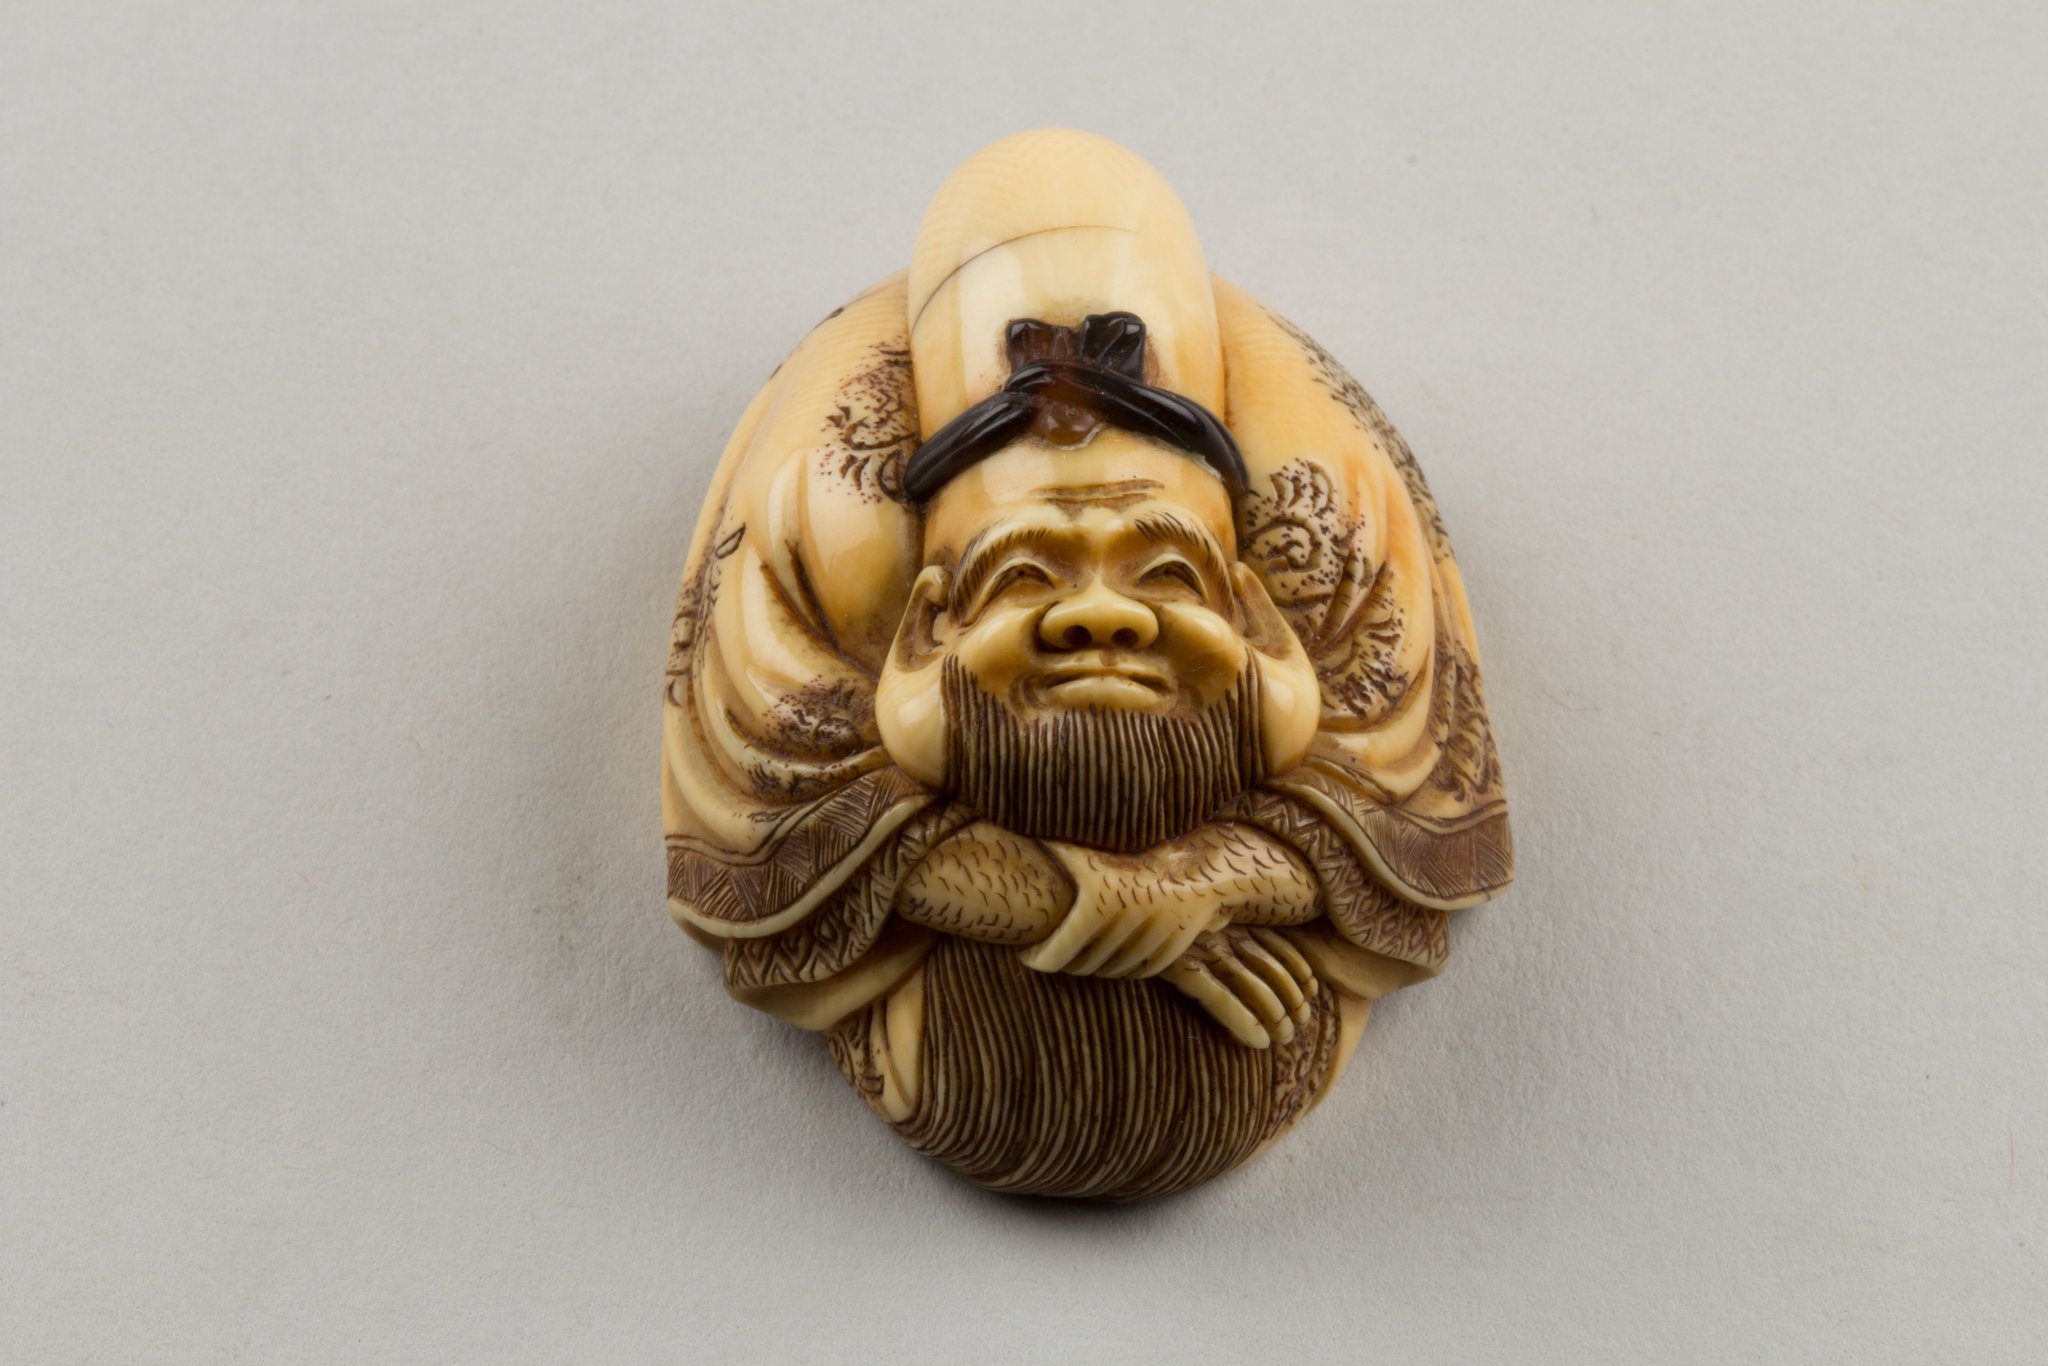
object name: netsuke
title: Netsuke of Fukurokuju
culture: japanese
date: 1767-1833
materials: ivory, shell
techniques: inlay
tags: men